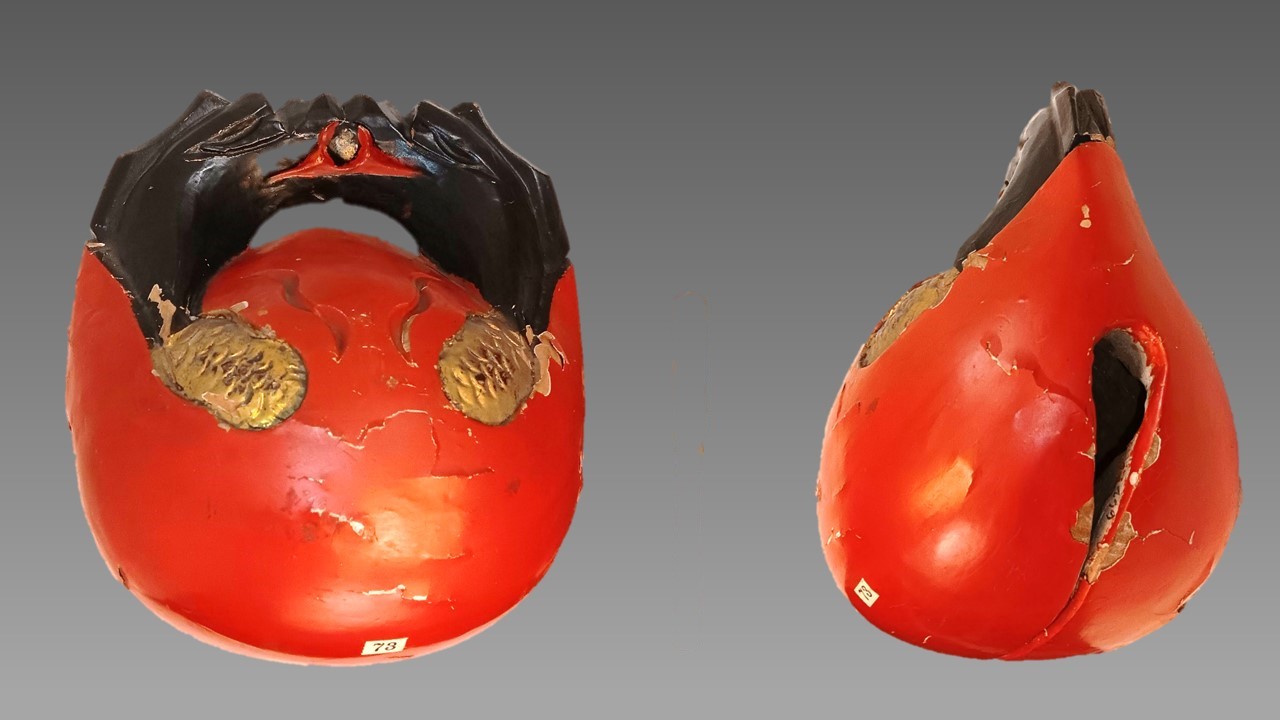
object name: mokugyo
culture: japanese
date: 1801-1900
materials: lacquer, wood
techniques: polychrome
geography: japan